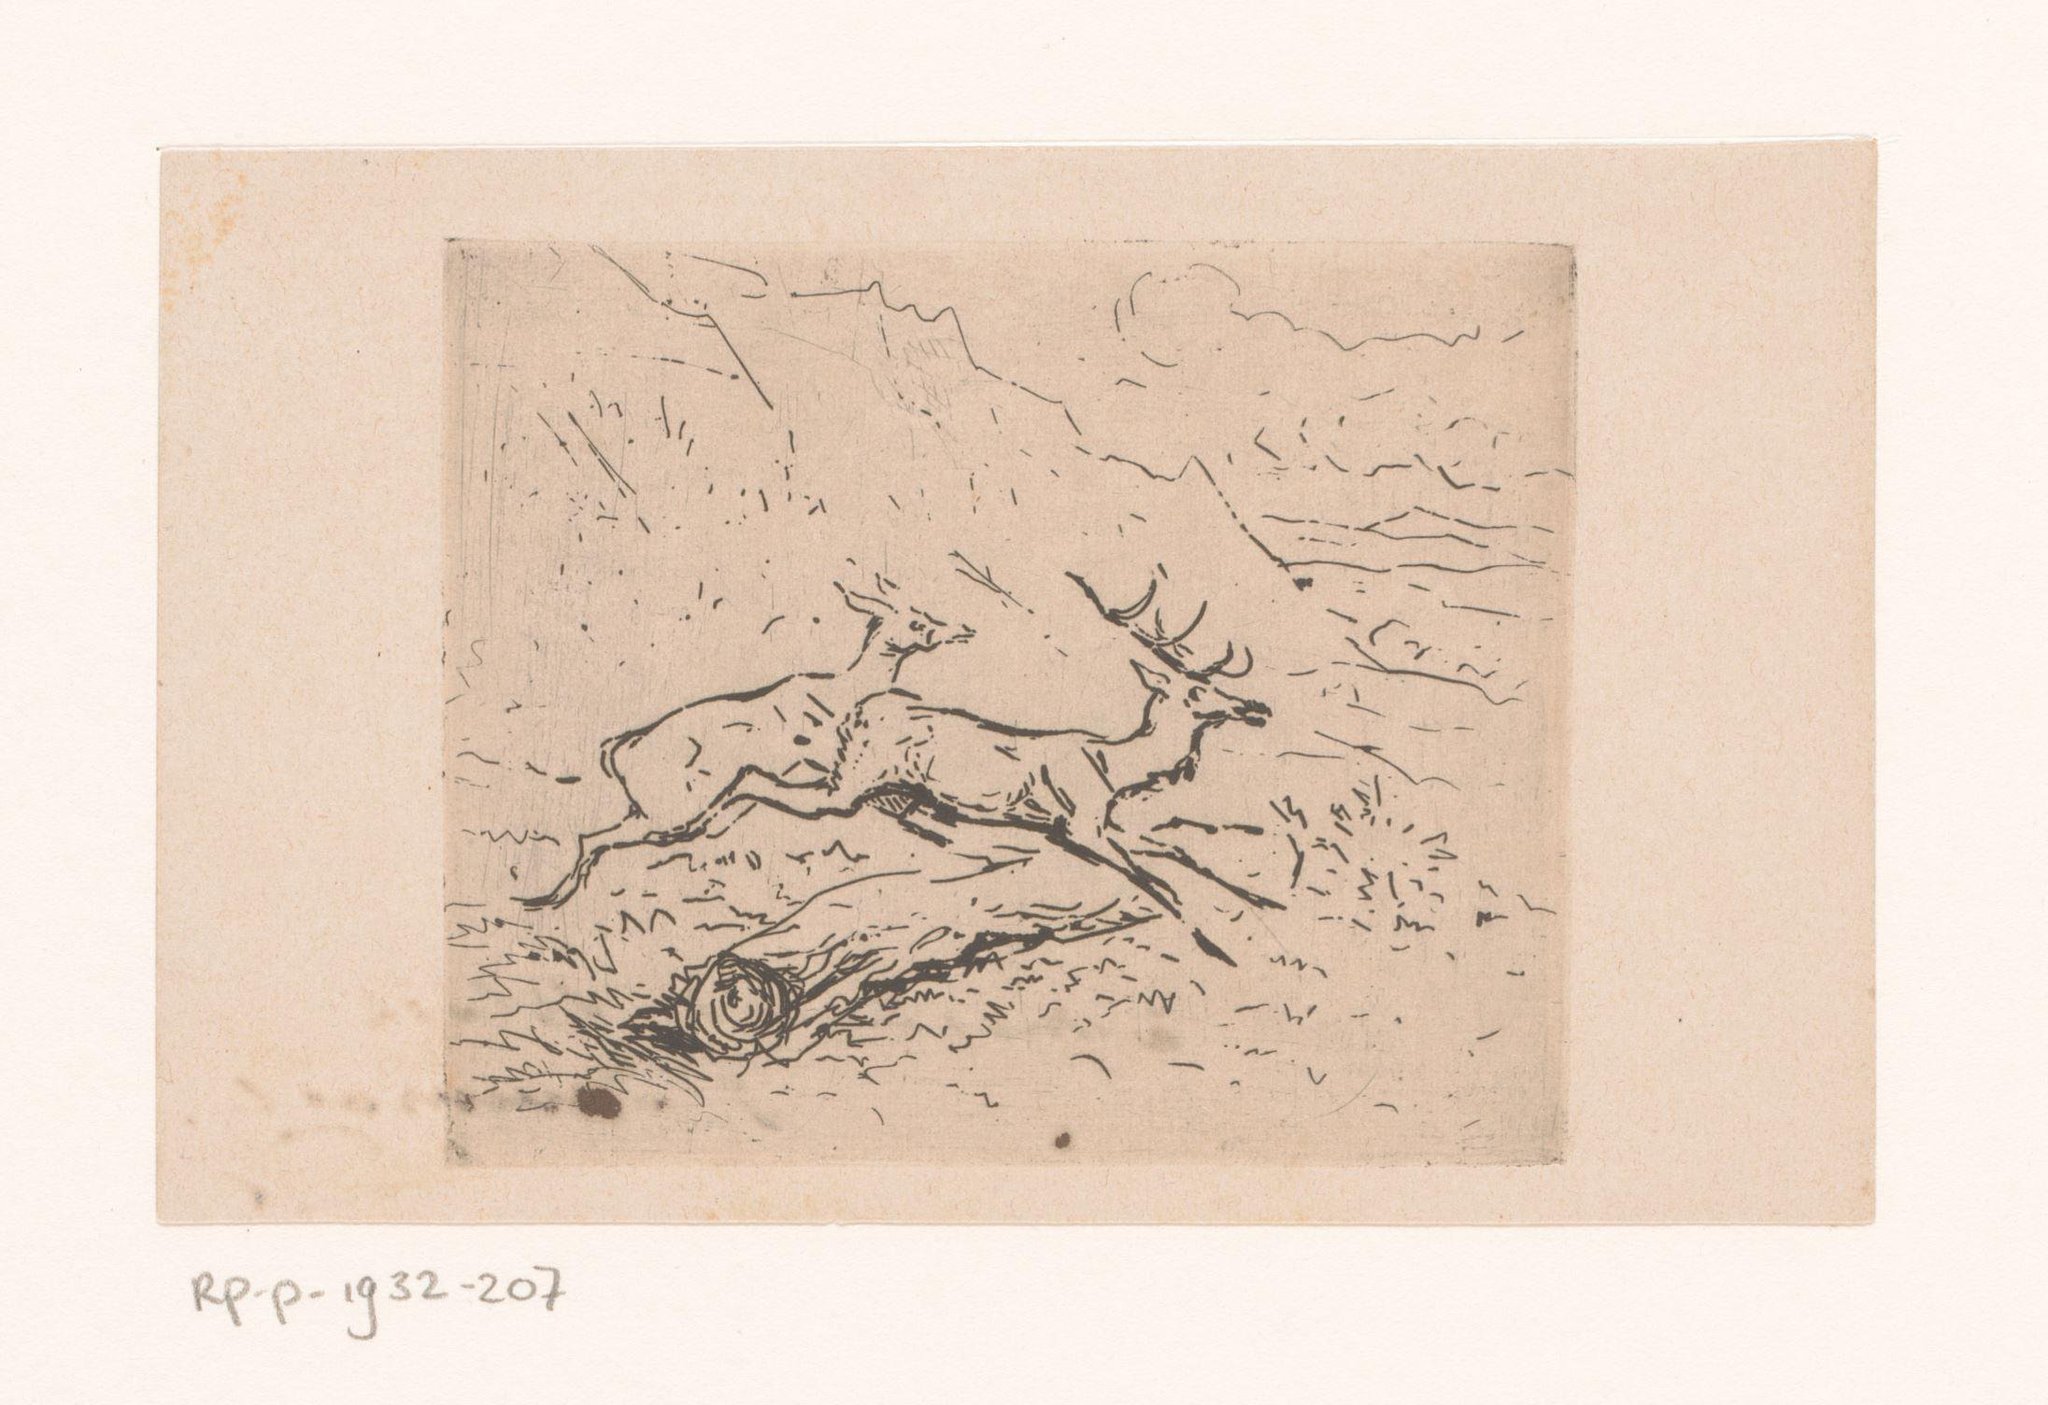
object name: print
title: Twee herten springen over een boomstam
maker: eugène françois de block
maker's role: draughtsman, painter, print maker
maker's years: 1812-1893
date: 1822-1893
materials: paper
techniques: etching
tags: hoofed animals: deer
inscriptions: inscription: ‘à mon cher file [...] à madame de Block J. [...]’